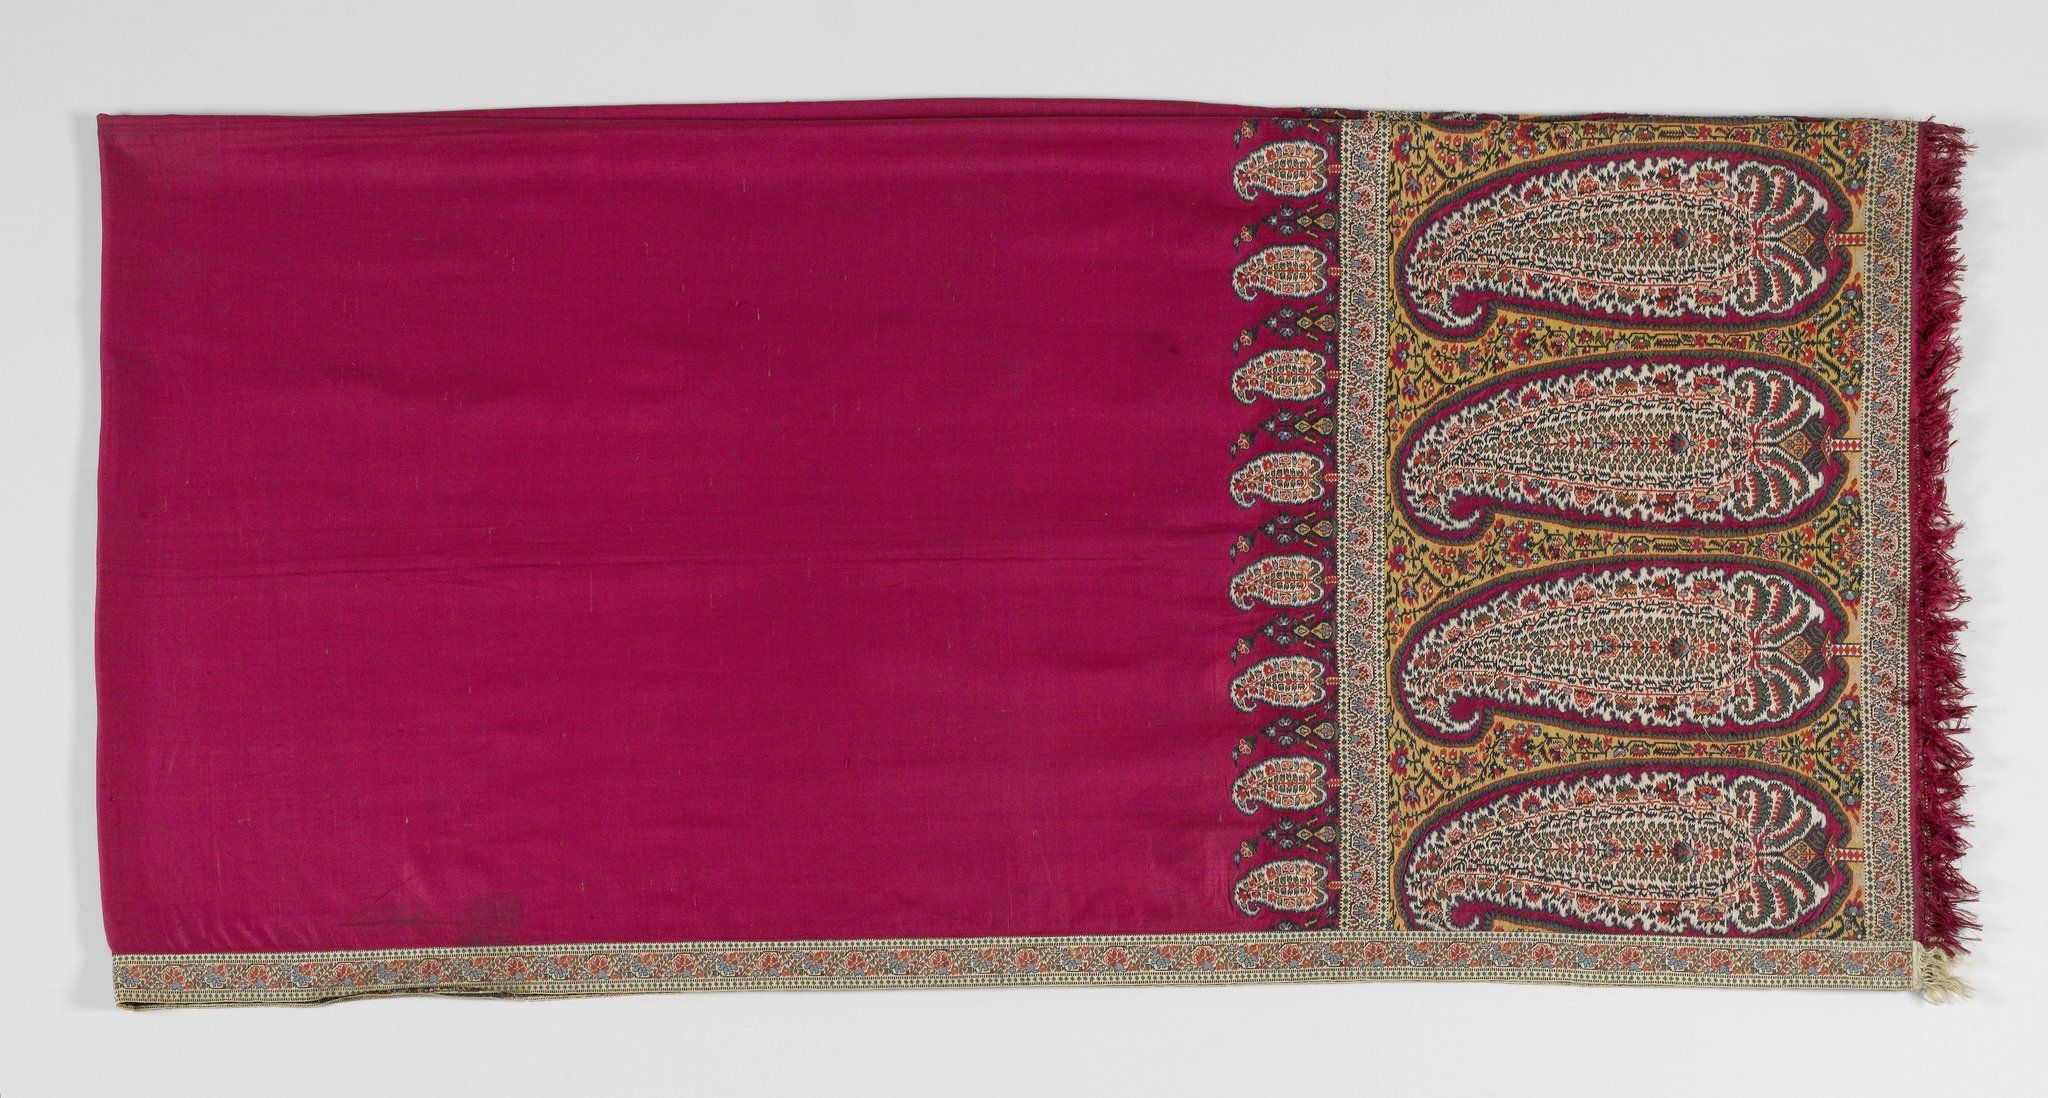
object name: scarf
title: Shawl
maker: Anonymous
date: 1815-1825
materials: cotton, silk, wool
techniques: weave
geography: paisley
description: The warm and colourful shawls that the British East India Company brought back from Kashmir were in high demand in Great Britain. Not everyone, however, could afford such luxurious imported items. This soon led weavers in England and Scotland to imitate them successfully. The method used in Europe differed from that in Kashmir; the reverse side of a shawl often gives away whether it is an original or an imitation.